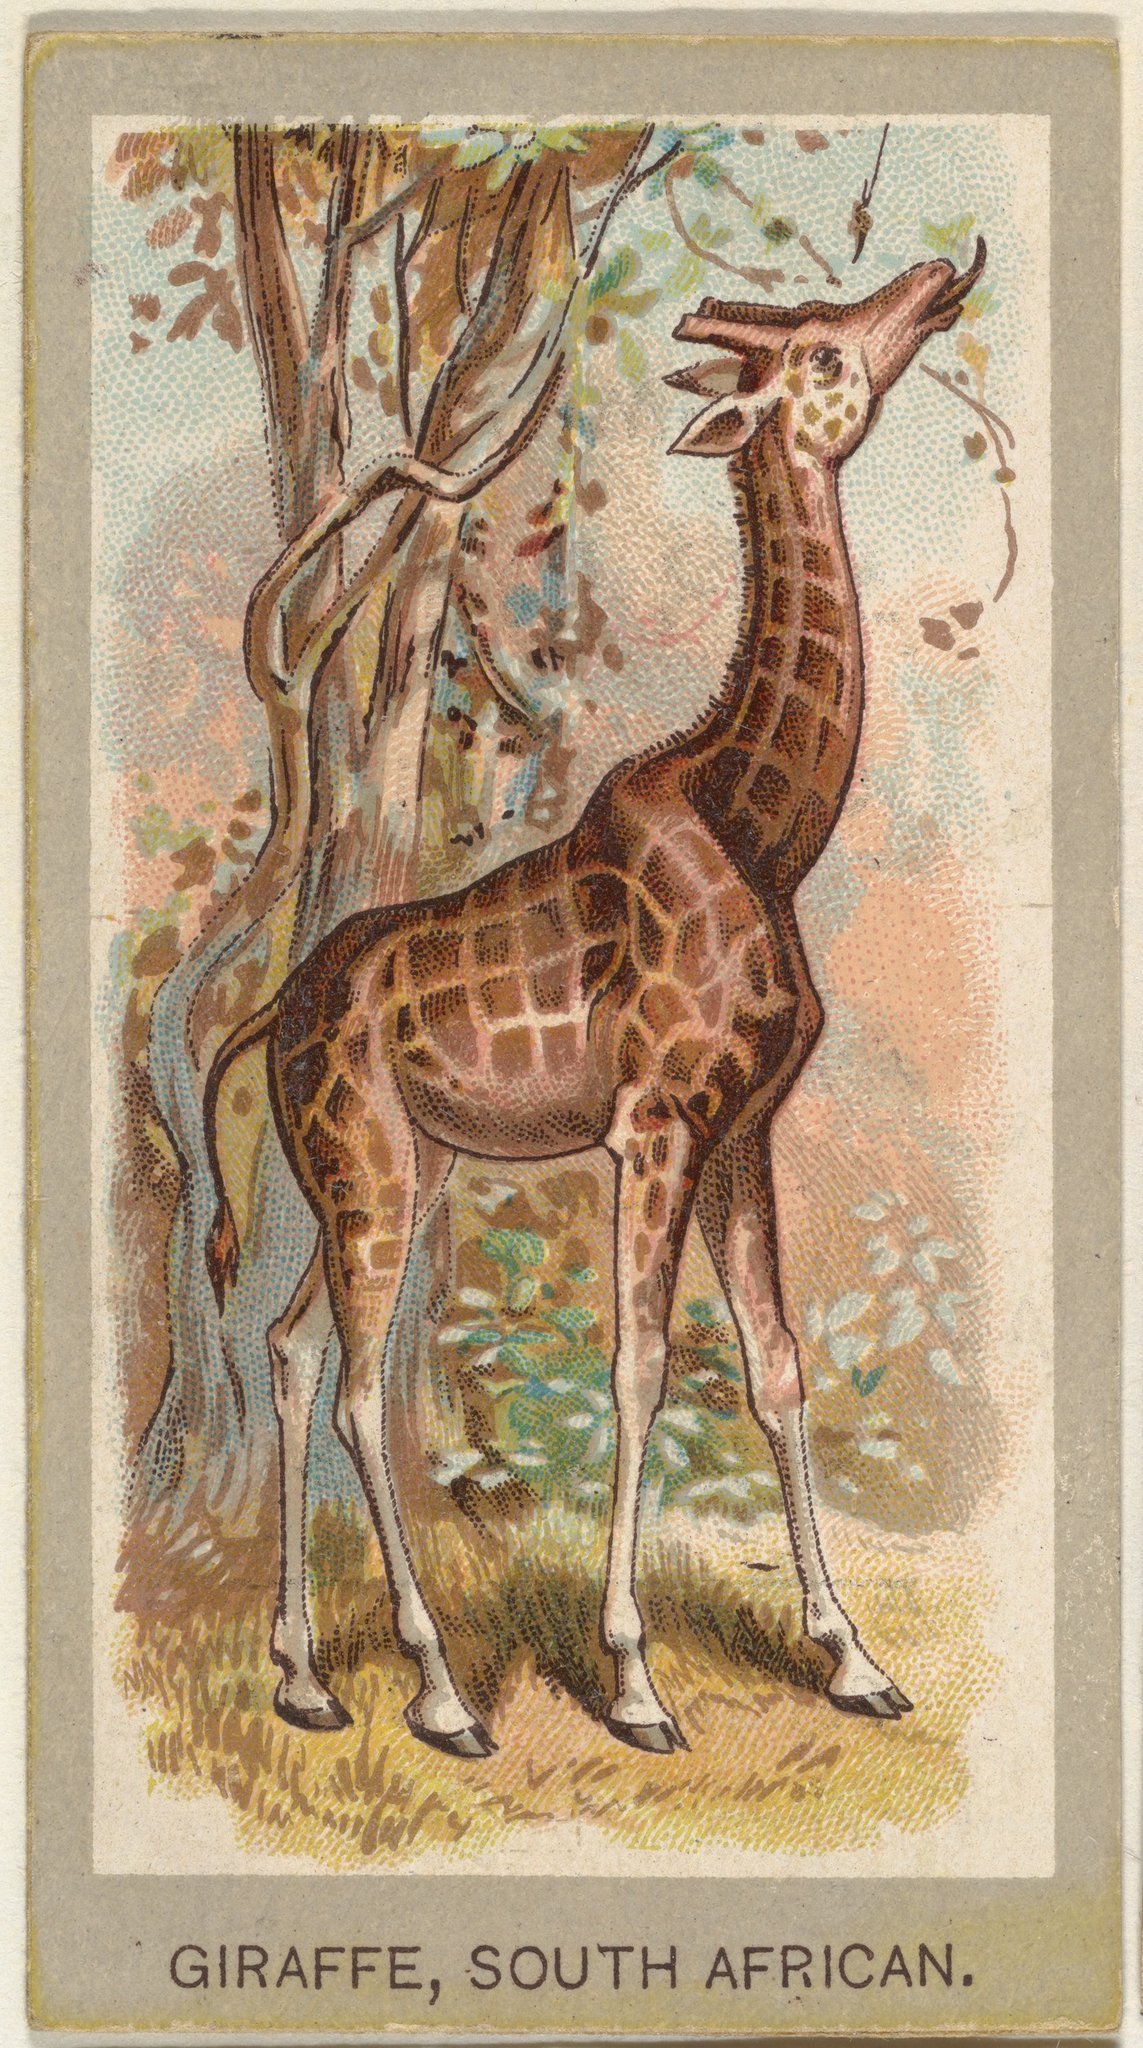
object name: print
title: Giraffe, South African, from the Animals of the World series (T180), issued by Abdul Cigarettes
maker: abdul cigarettes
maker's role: publisher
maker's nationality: american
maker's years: 1881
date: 1881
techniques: color lithograph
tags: giraffes